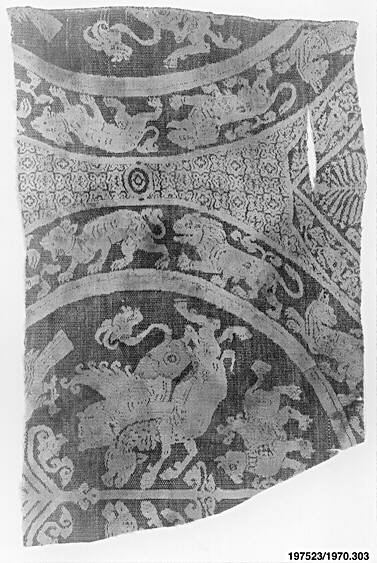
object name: textile fragment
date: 901-1100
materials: silk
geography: iran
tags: lions